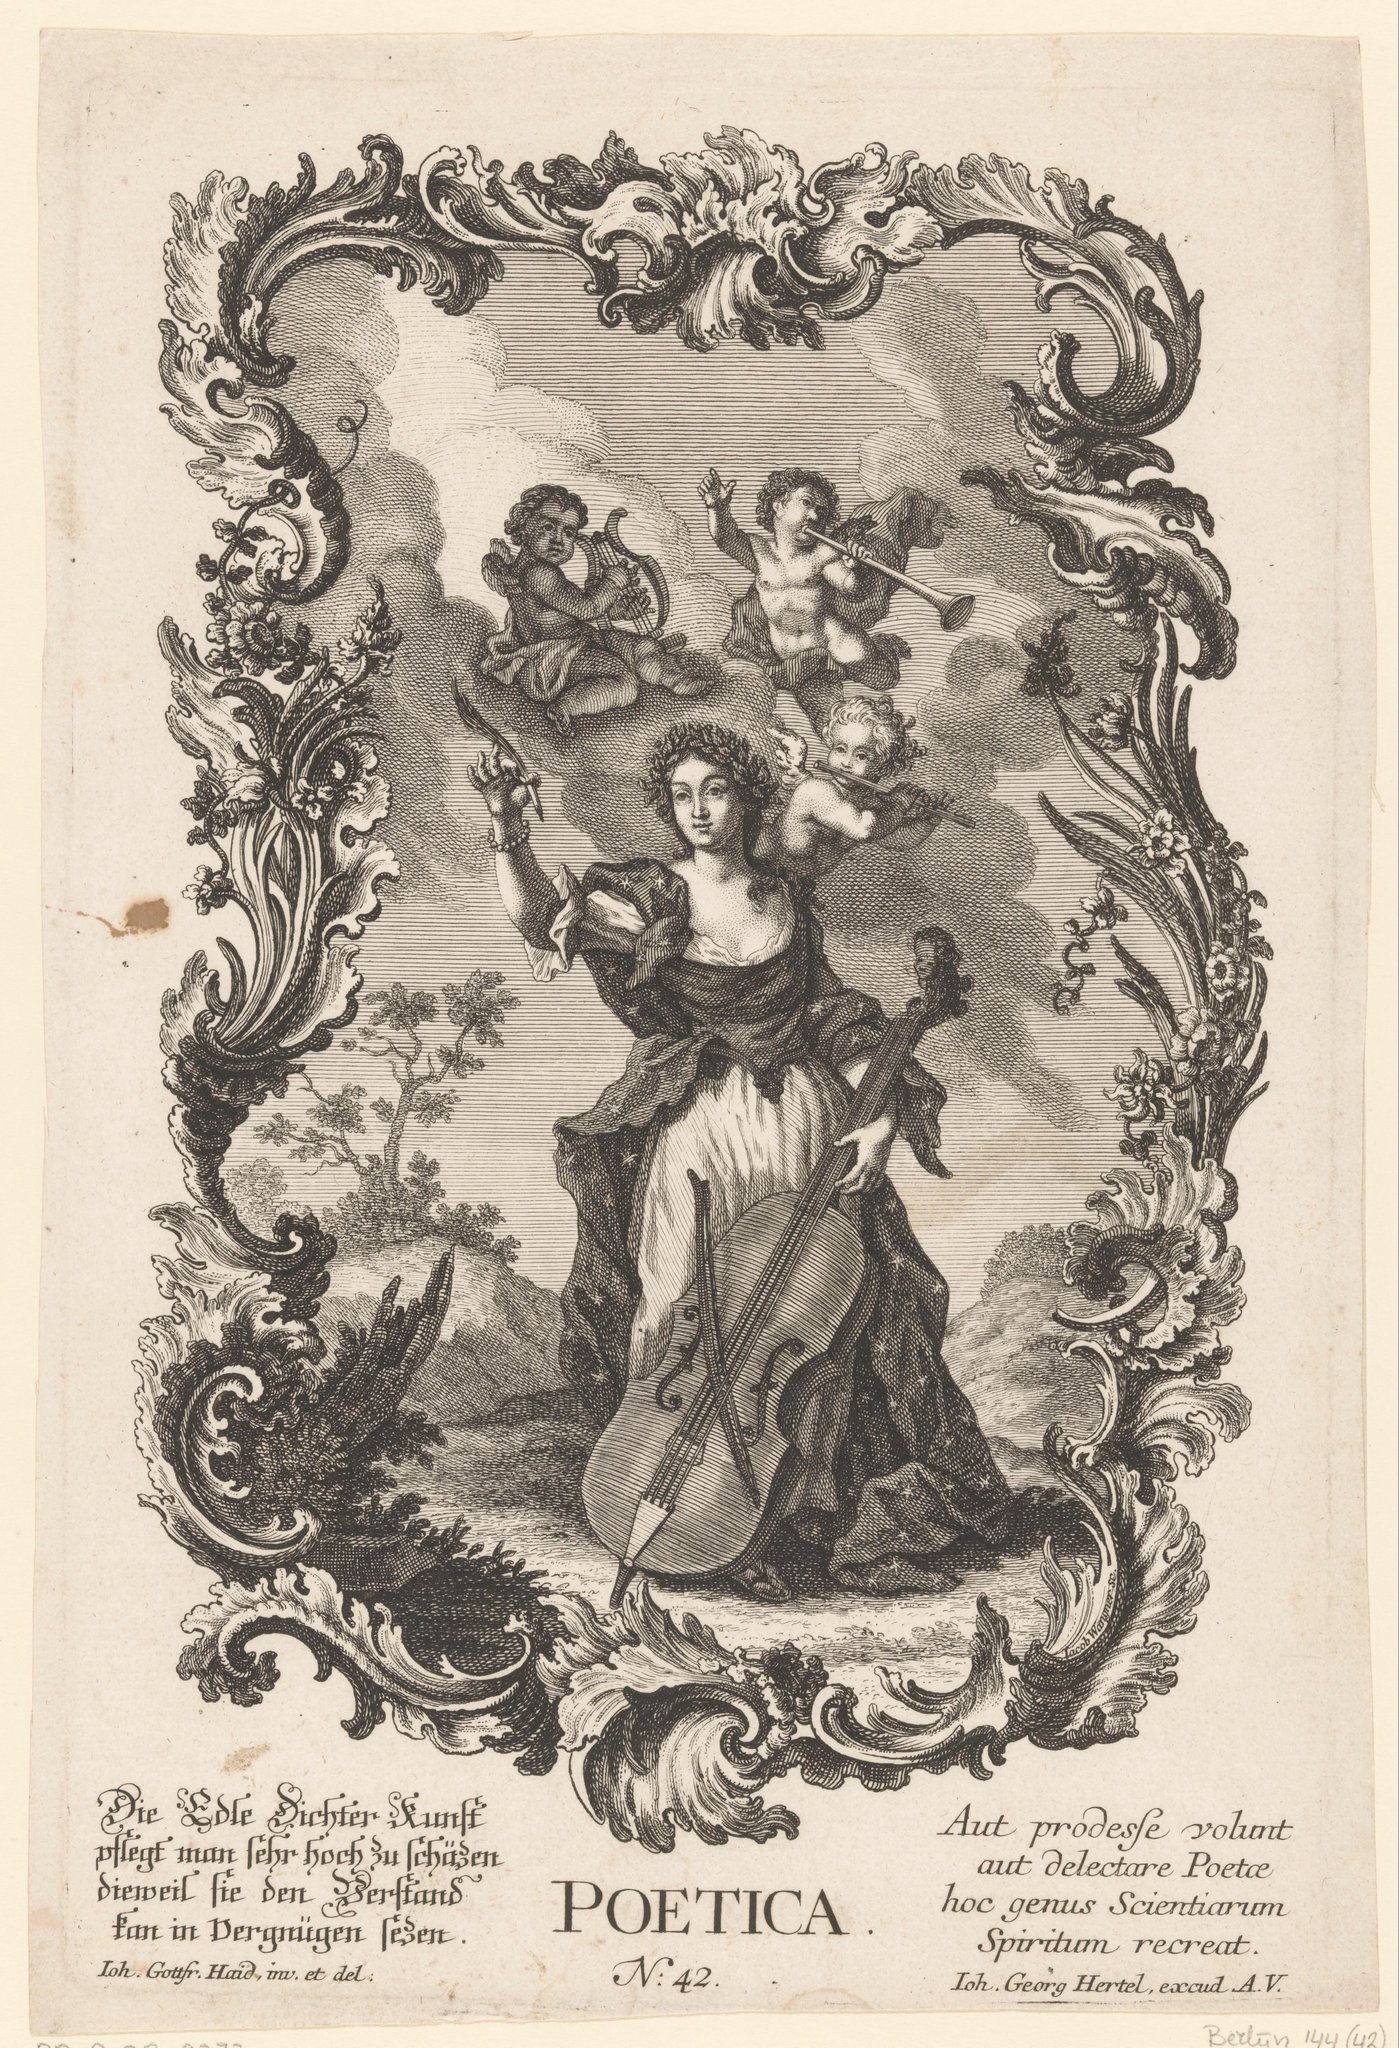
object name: ornament print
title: Allegorie van de poëzie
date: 1745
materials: paper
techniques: etching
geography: augsburg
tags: angels singing, making music, symbolic representations, allegories and emblems ~ poetry; 'poesia' (ripa), standing figure - aa - female human figure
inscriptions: collector's mark: Lugt 2228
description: Allegorie van de poëzie, omgeven door een rocaille omlijsting. In een landschap staat een vrouw met een schrijfveer en een snaarinstrument. In de wolken boven haar zitten drie musicerende engelen. In de ondermarge een vierregelige Duitse en Latijnse tekst. Uitgeversnummer 42.